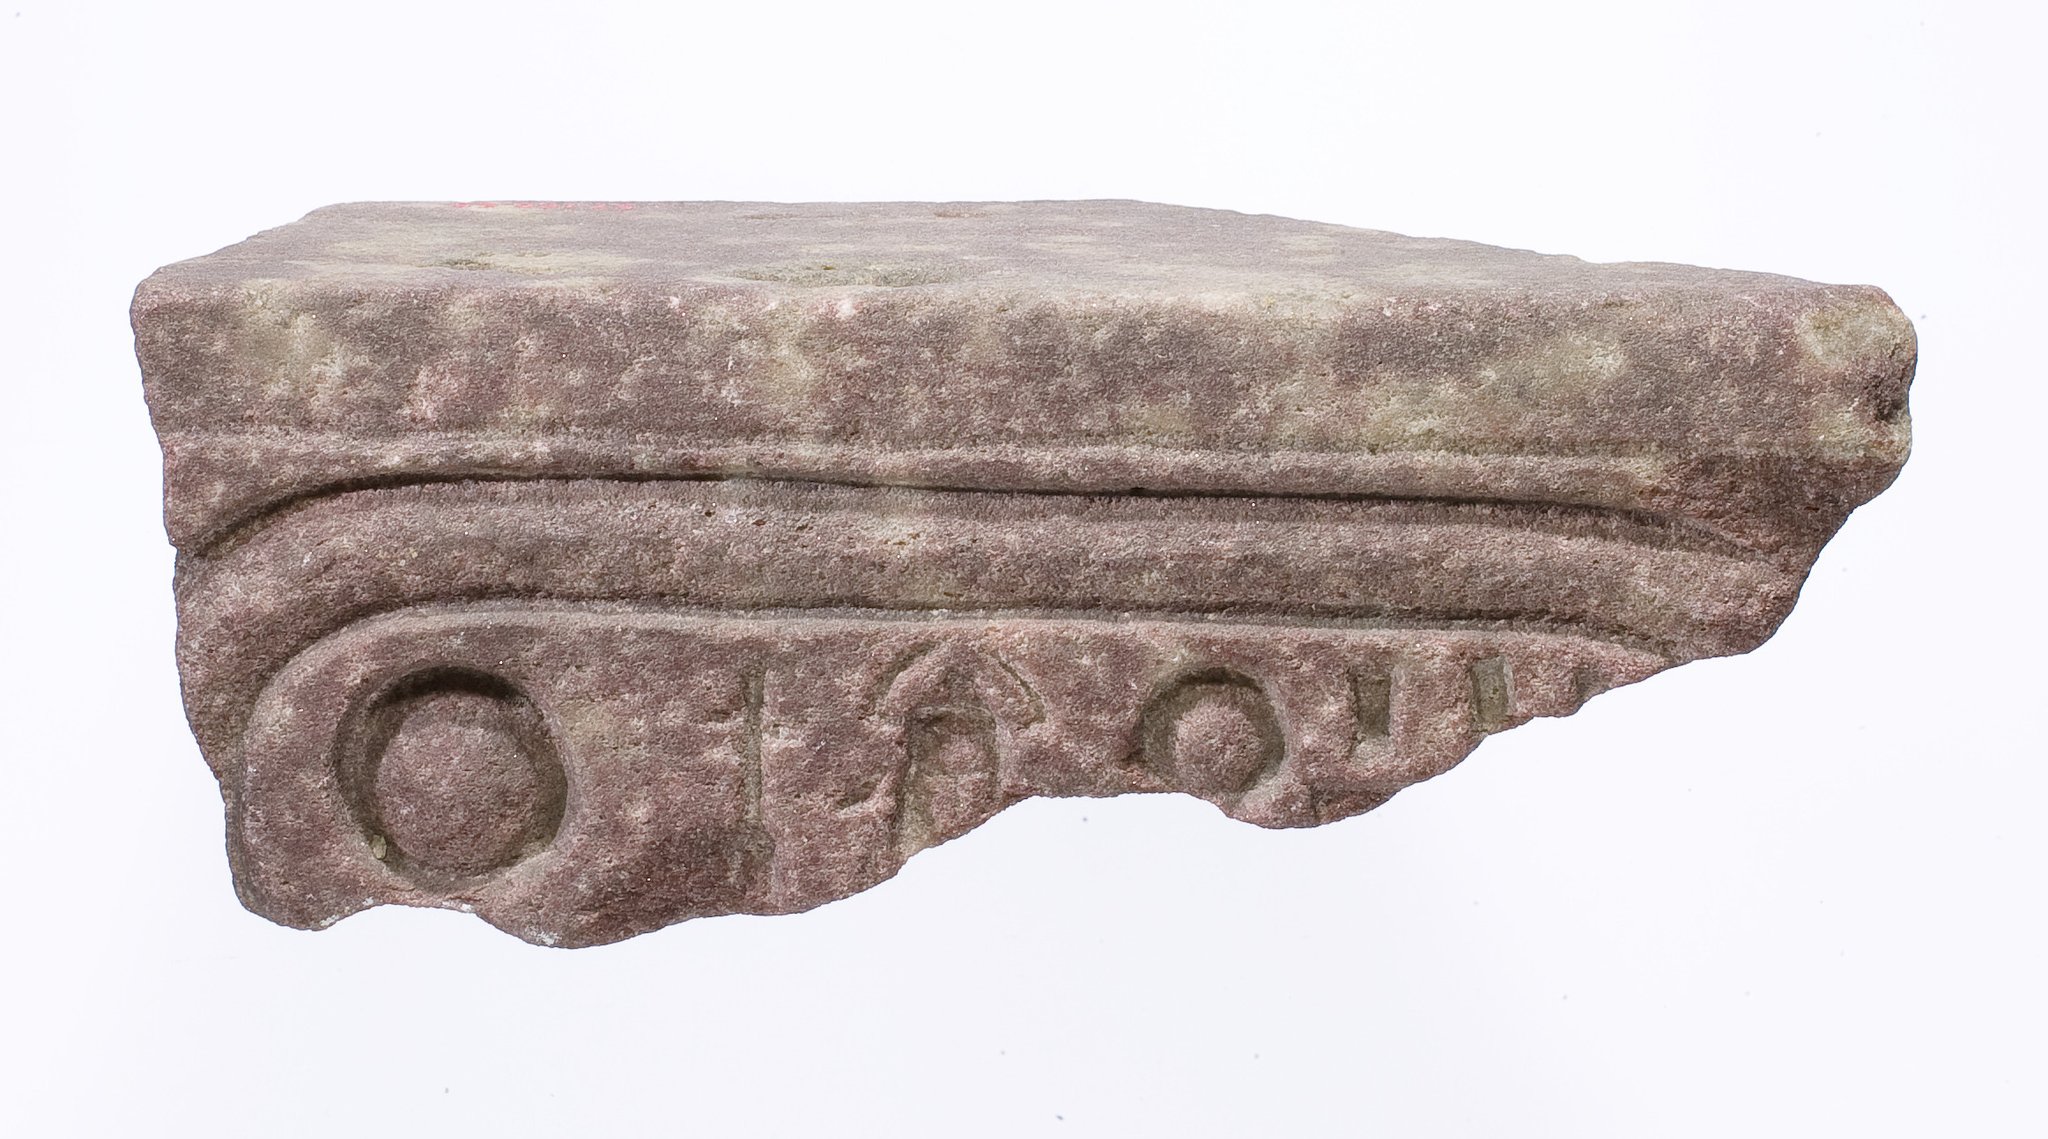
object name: prenomen of akhenaten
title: Element with the prenomen of Akhenaten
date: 1353-1336 BCE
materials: quartzite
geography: egypt